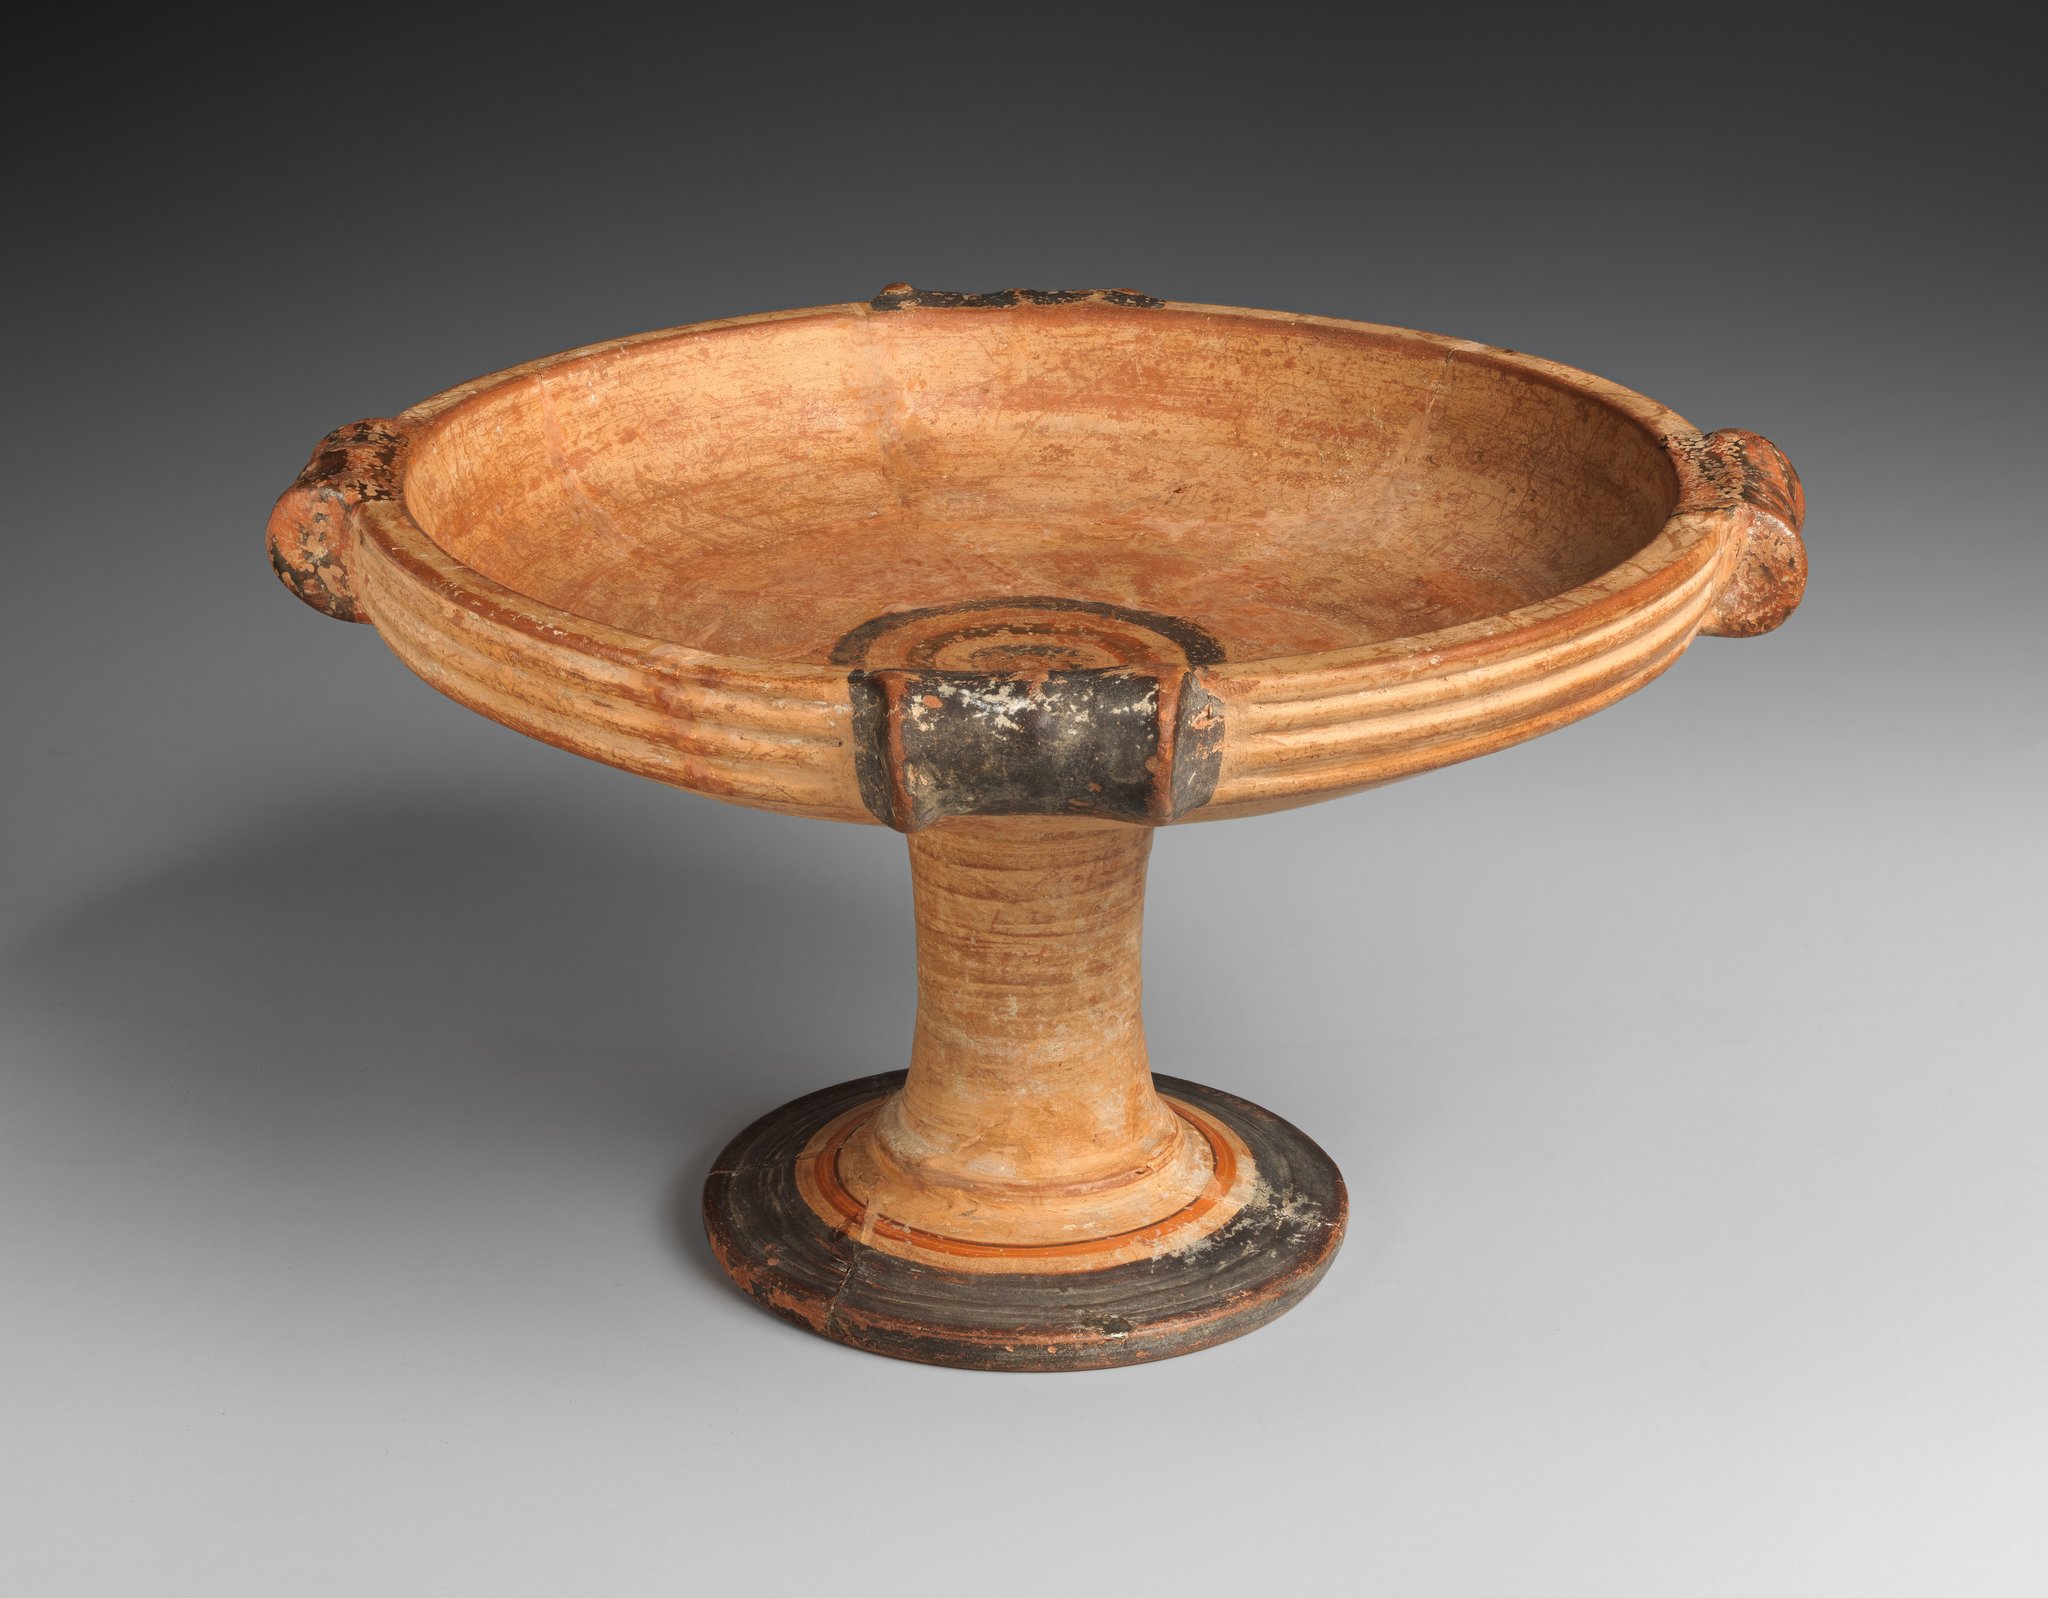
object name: dish, standed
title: Terracotta stemmed dish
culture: lydian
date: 634-568 BCE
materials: terracotta